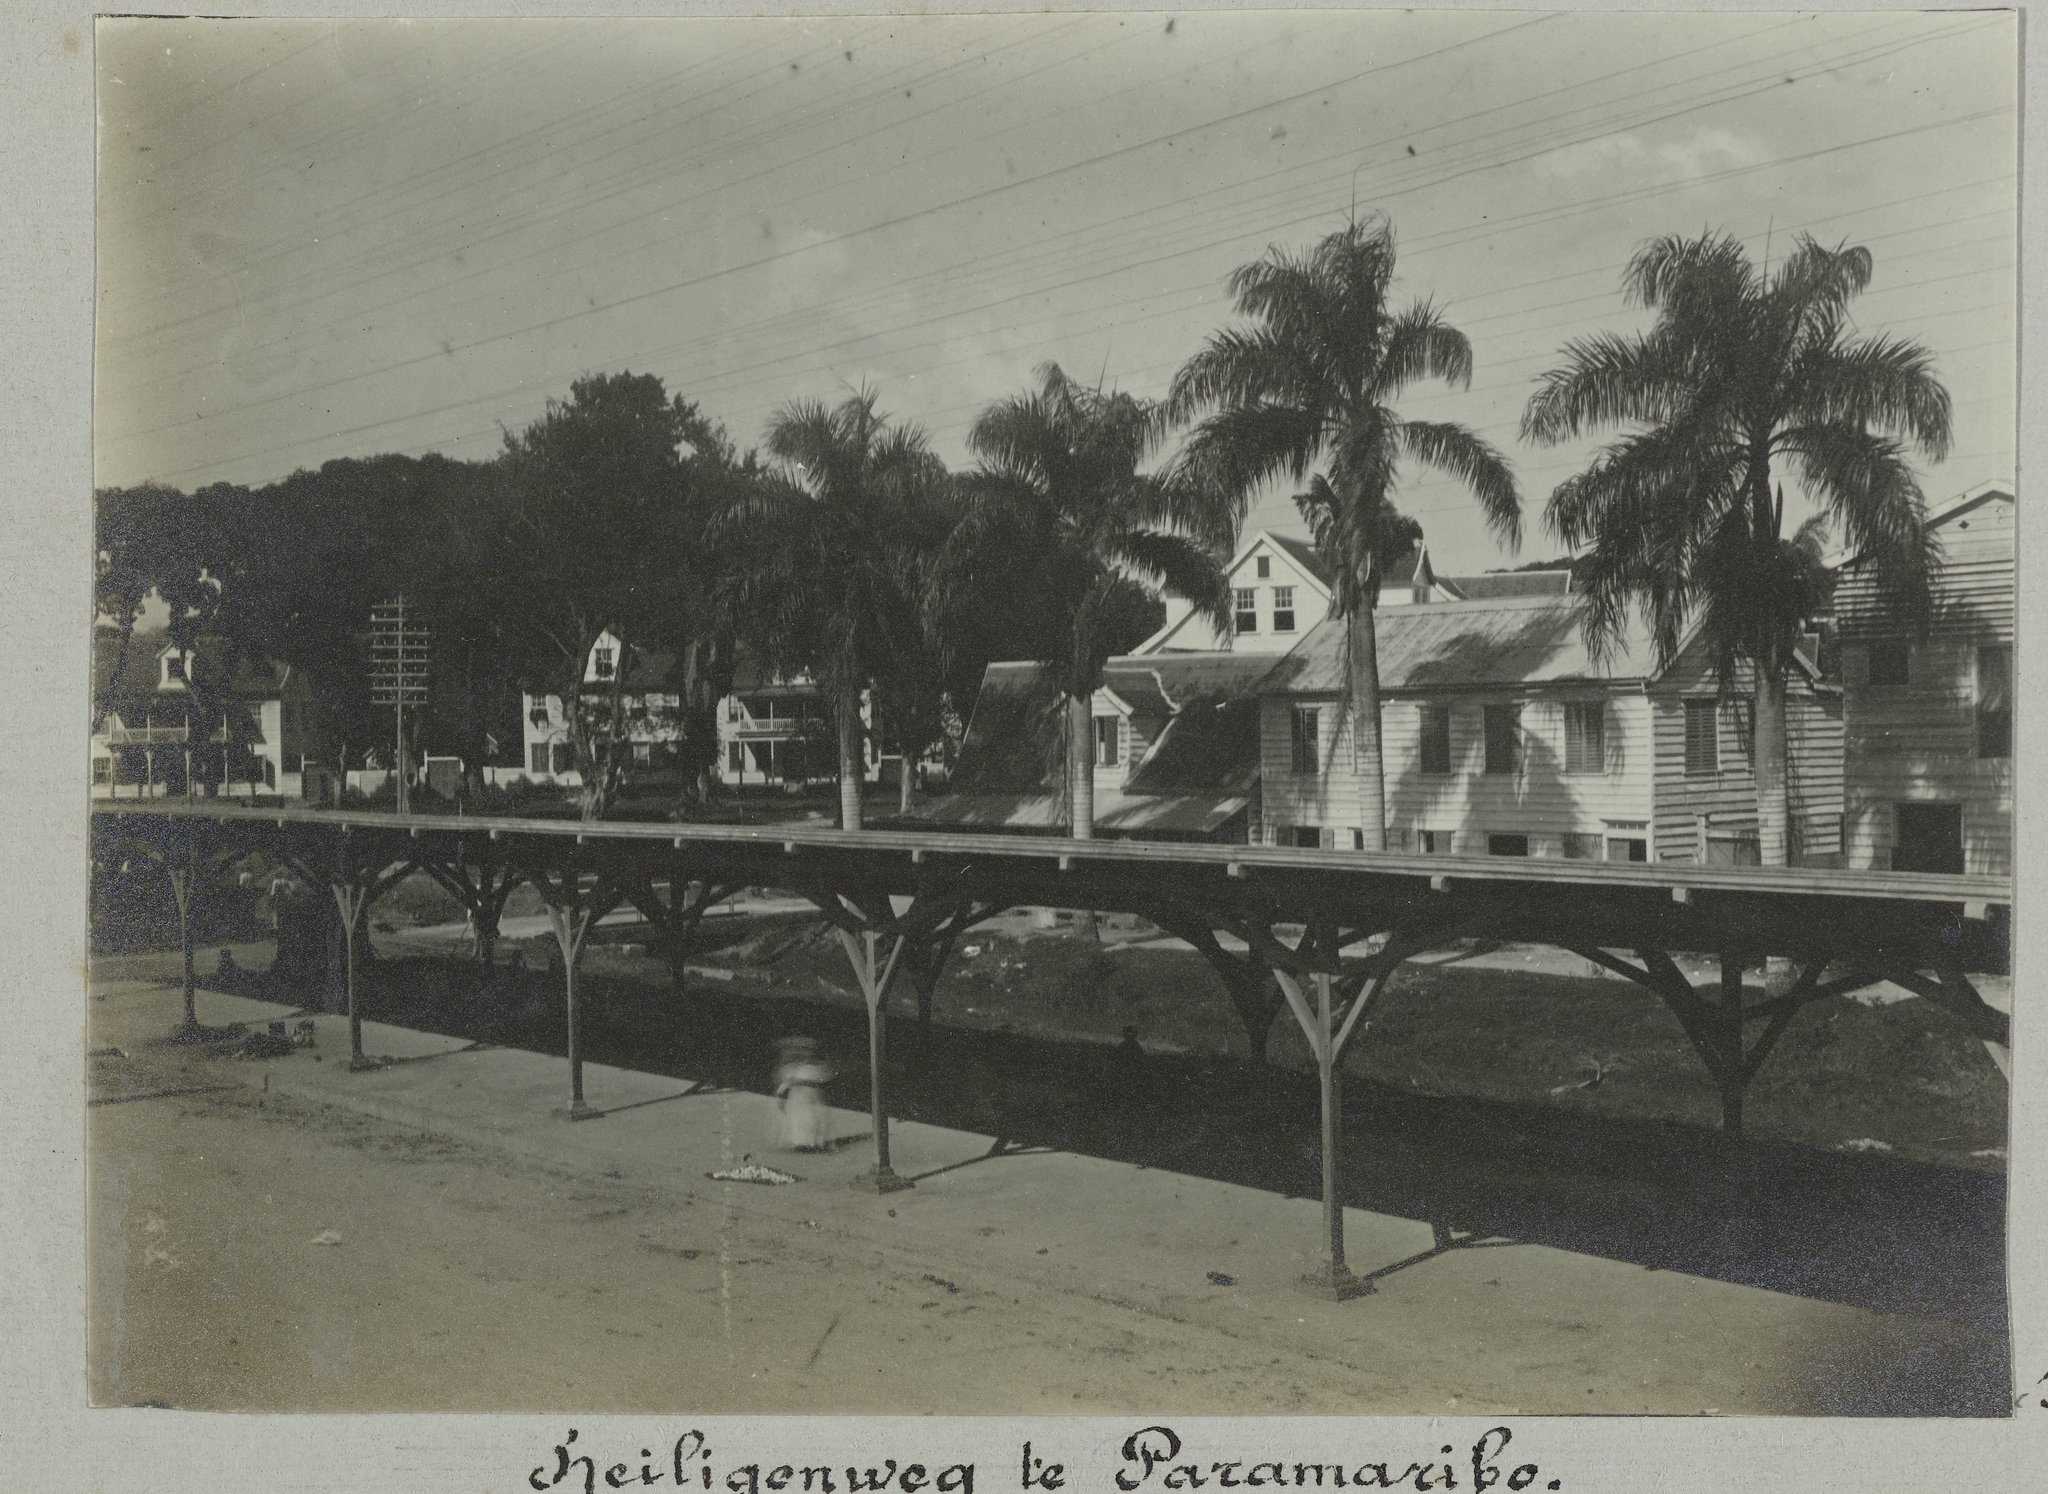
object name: photograph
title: Heiligenweg te Paramaribo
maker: hendrik doijer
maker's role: engineer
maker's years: 1863-1925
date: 1903-1910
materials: photographic support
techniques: gelatin silver print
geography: suriname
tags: suriname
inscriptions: inscription: ‘3. / Heiligenweg te Paramaribo’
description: Gezicht op de Heiligenweg met een overdekte passage, te Paramaribo. Onderdeel van het fotoalbum Souvenir de Voyage (deel 1), over het leven van de familie Doijer in en rond de plantage Ma Retraite in Suriname in de jaren 1903-1910.